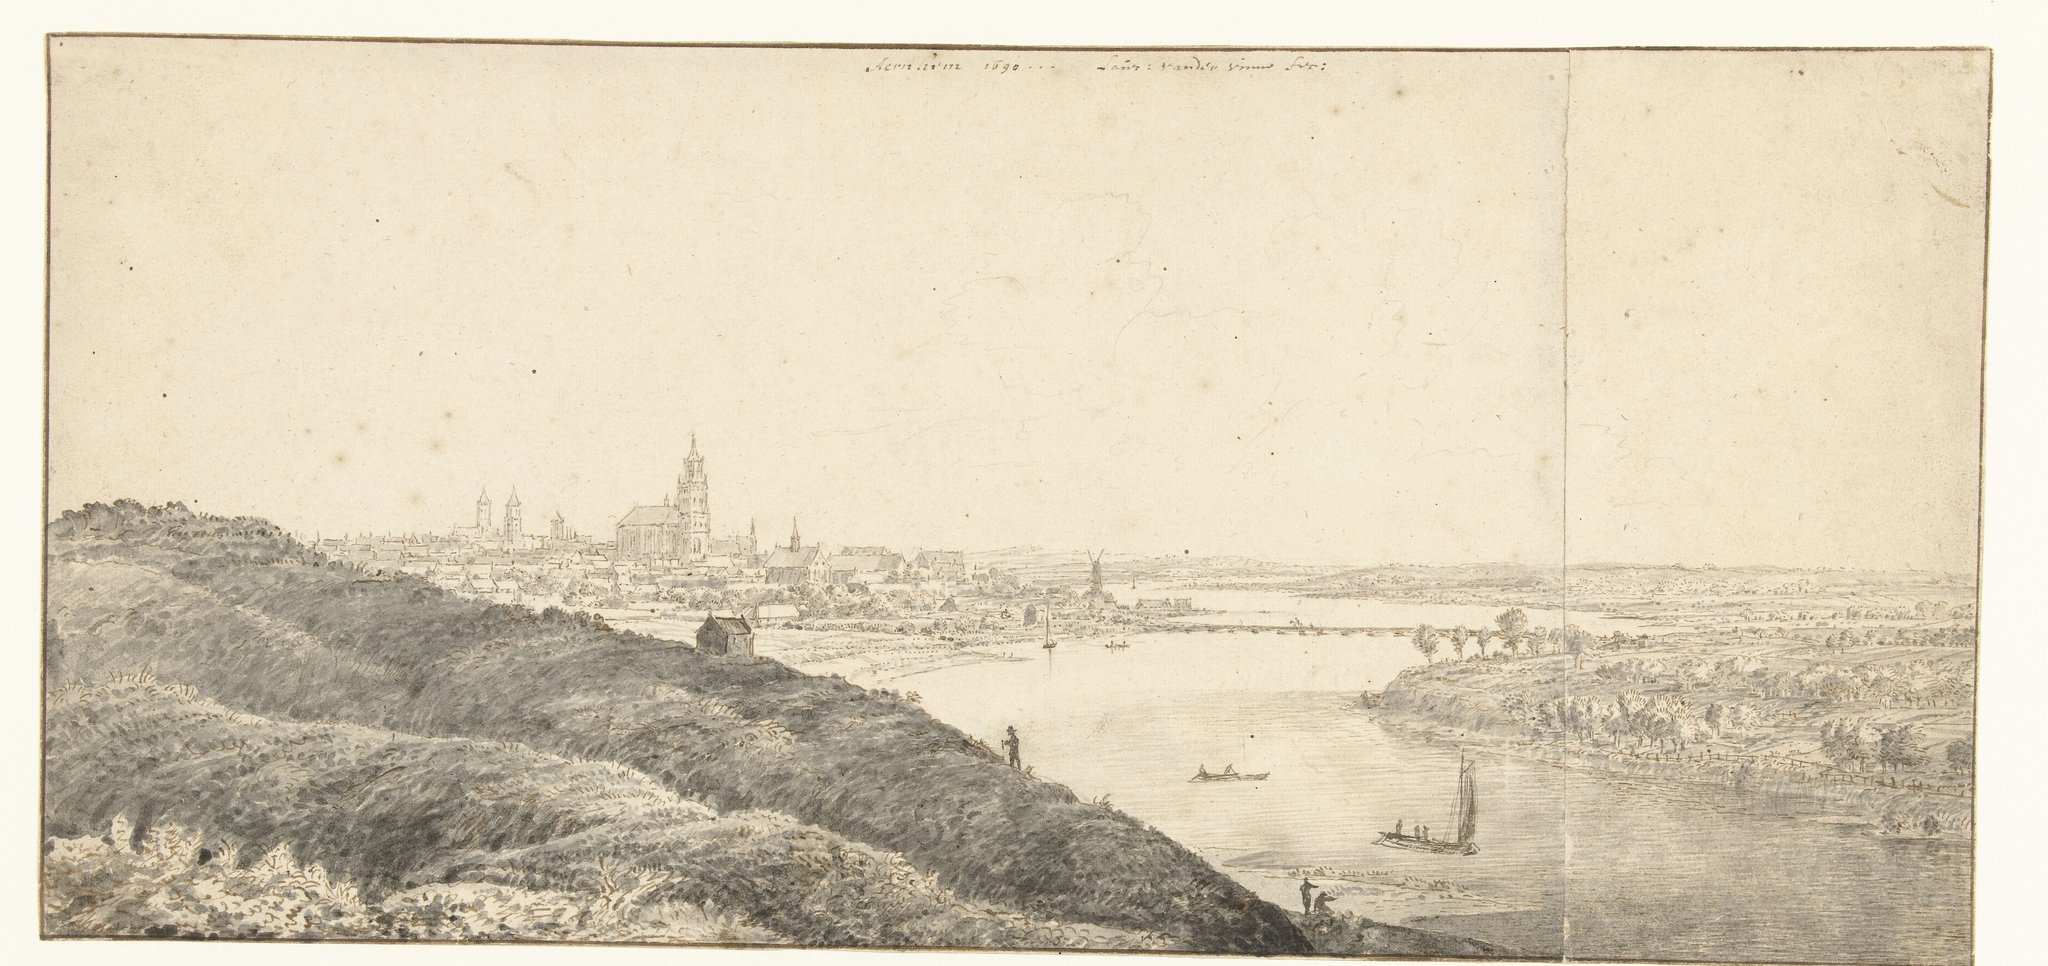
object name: drawing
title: Gezicht op Arnhem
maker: laurens vincentsz. van der vinne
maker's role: draughtsman, print maker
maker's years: 1658-1729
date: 1690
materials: ink, paper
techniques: brush, pen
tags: prospect of city, town panorama, silhouette of city, arnhem